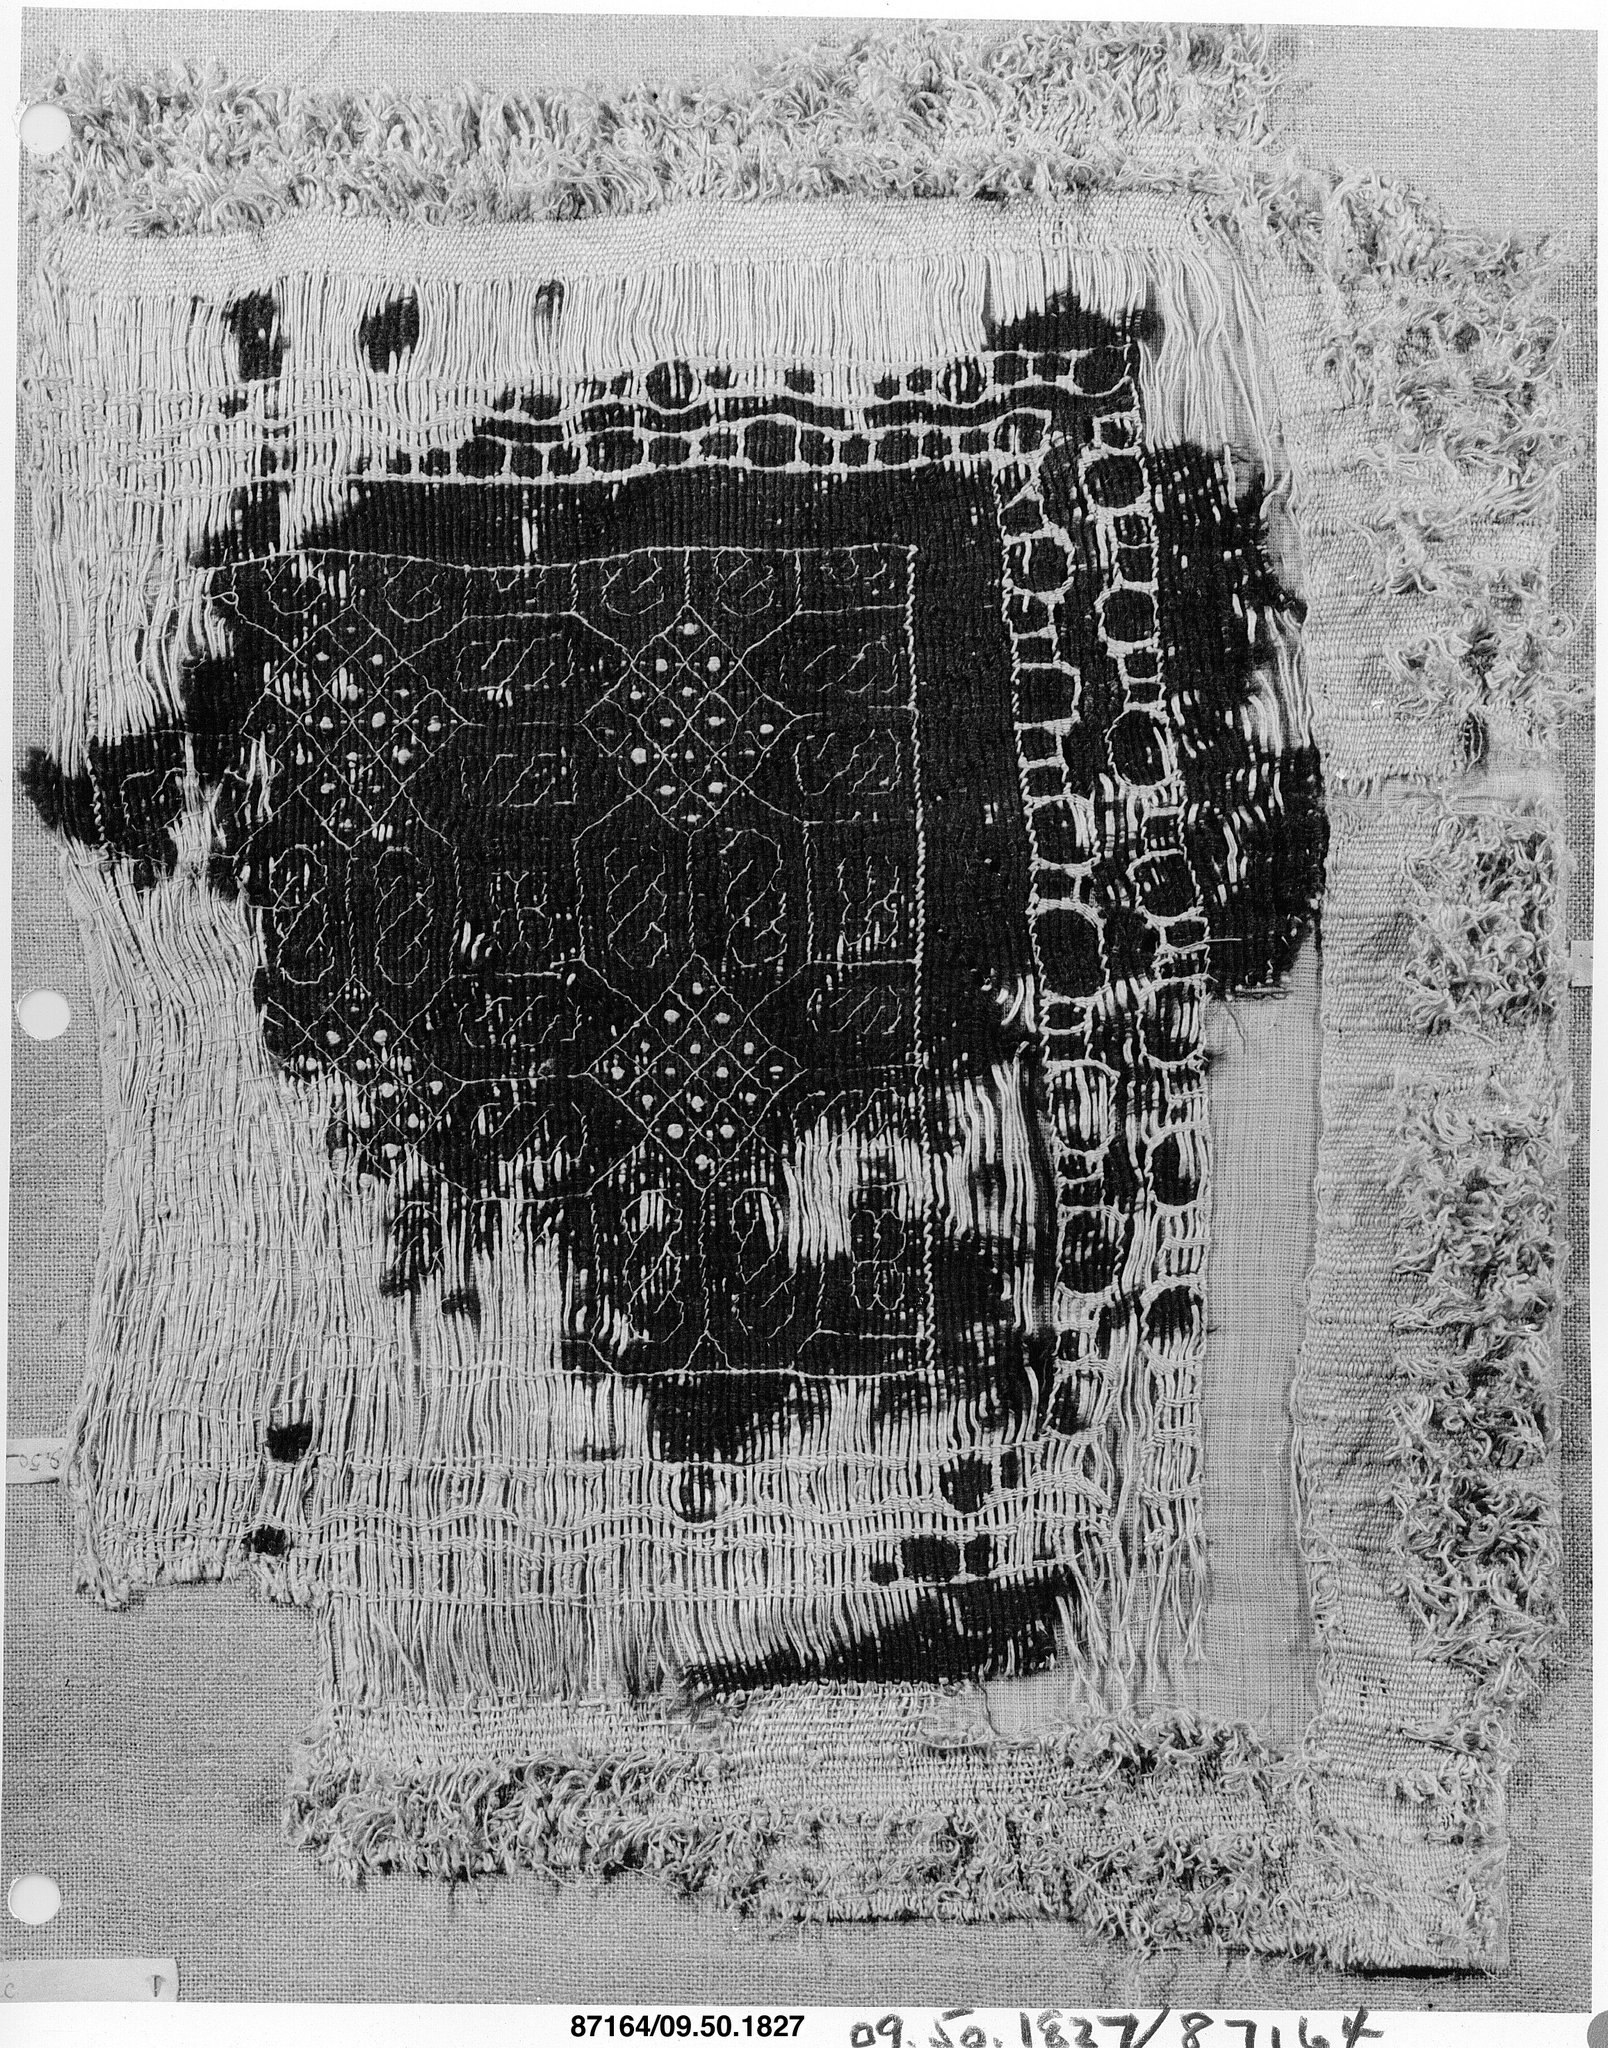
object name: panel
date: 301-500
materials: linen, wool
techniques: weave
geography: egypt